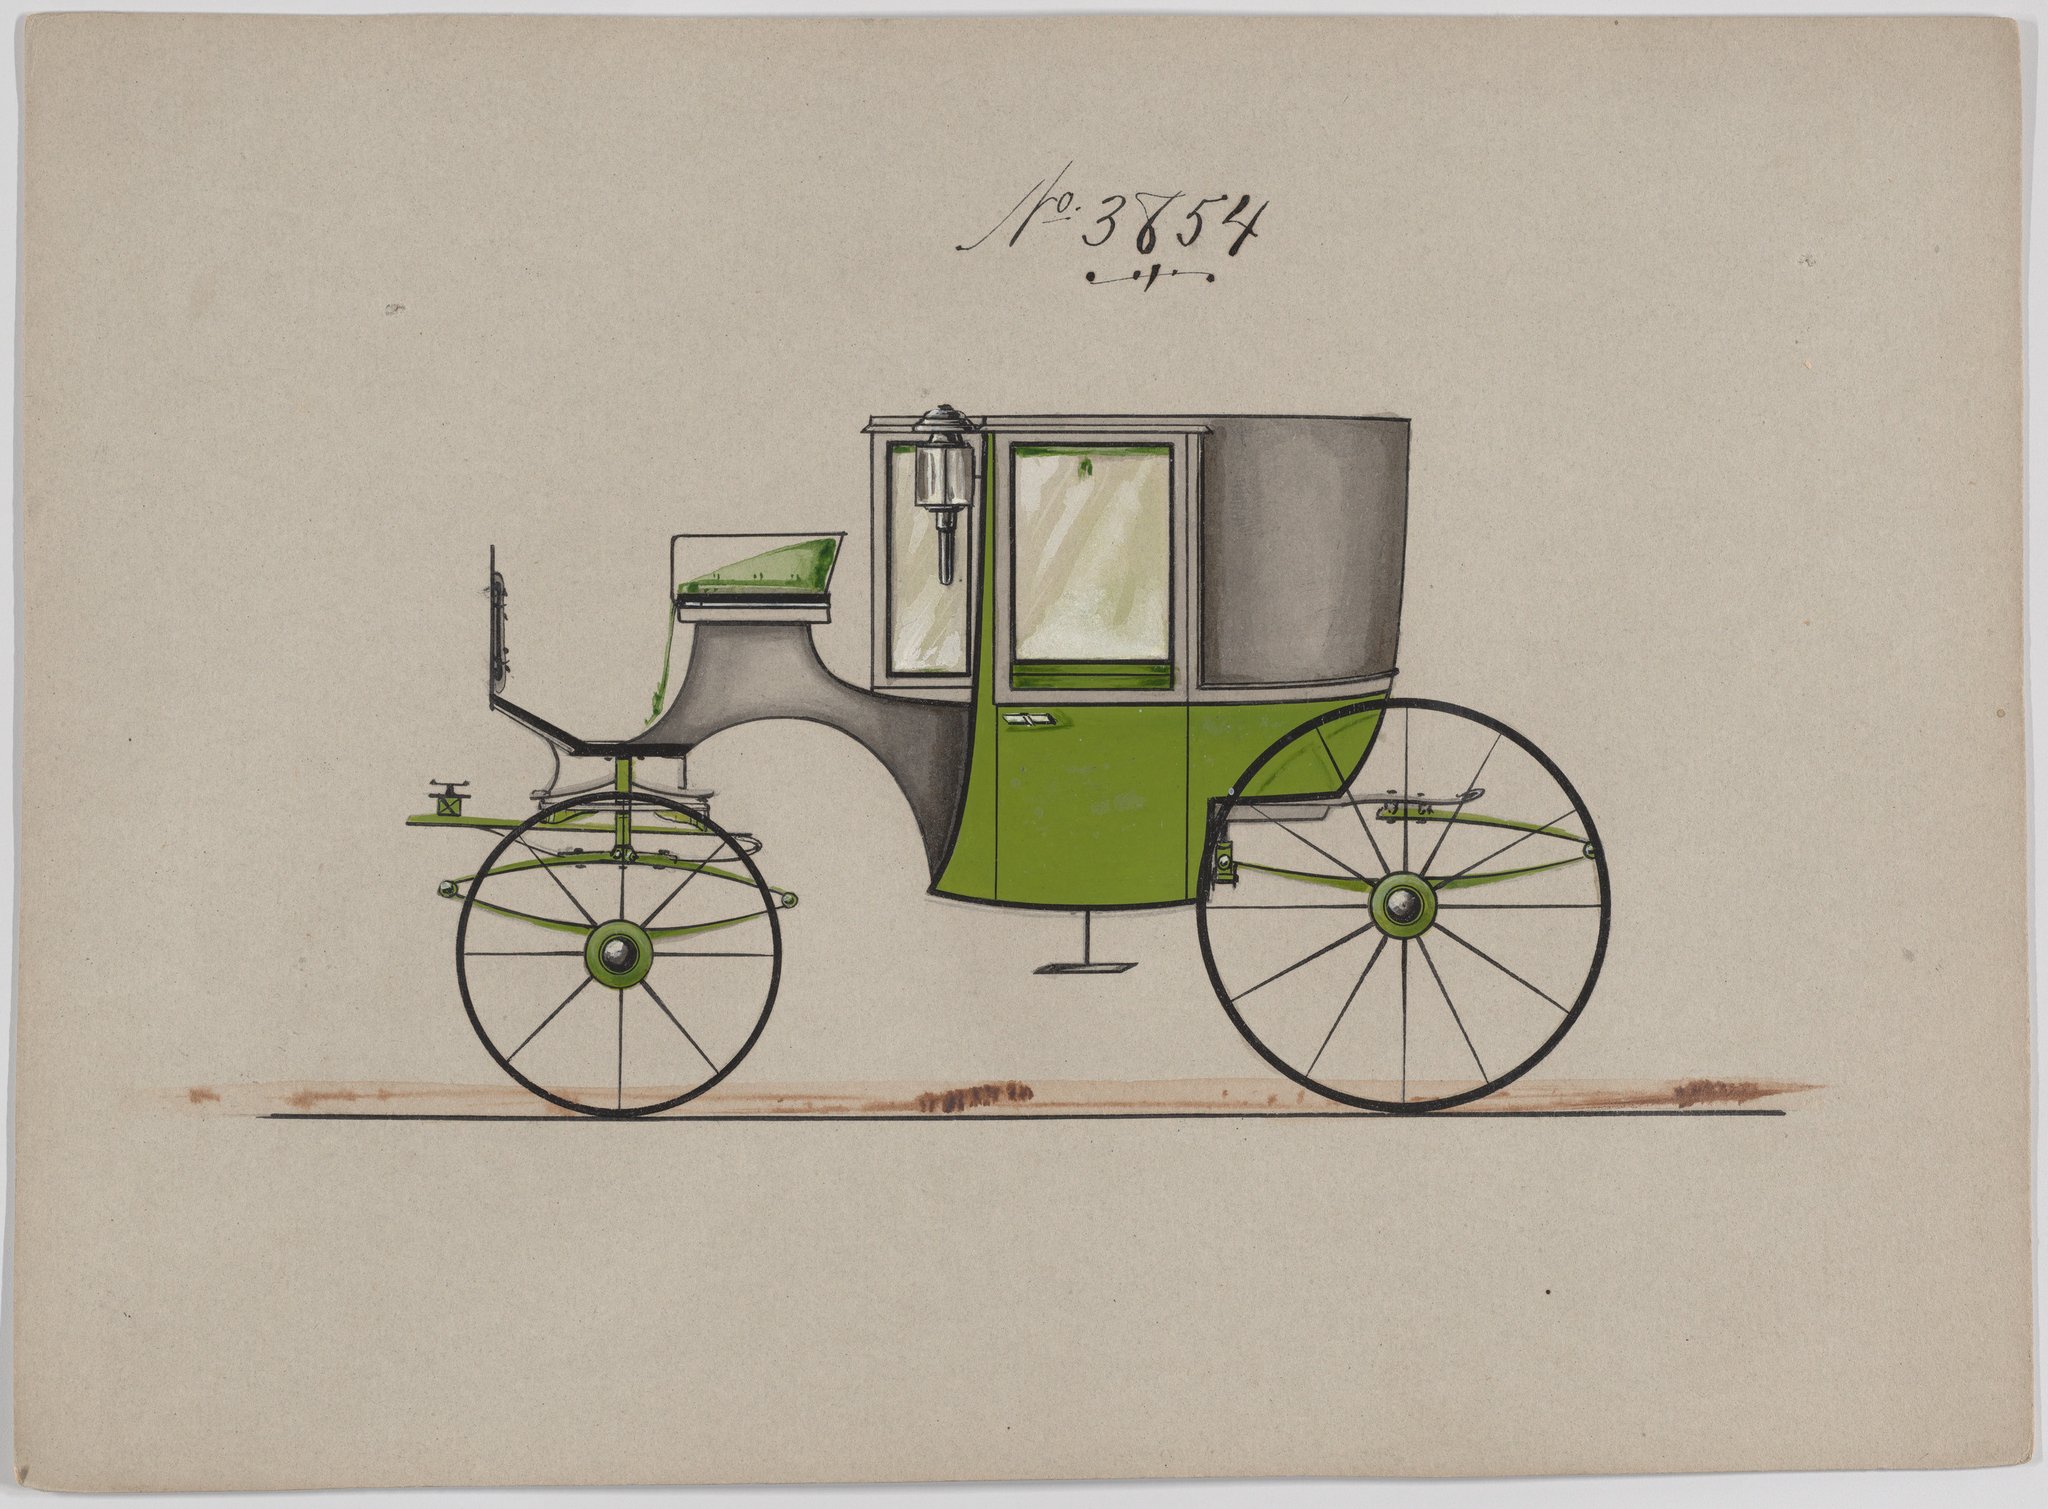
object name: drawing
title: Design for Coupé, no. 3854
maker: brewster & co.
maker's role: manufacturer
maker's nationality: american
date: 1883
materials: gouache, gum arabic, ink, watercolor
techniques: pen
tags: carriages